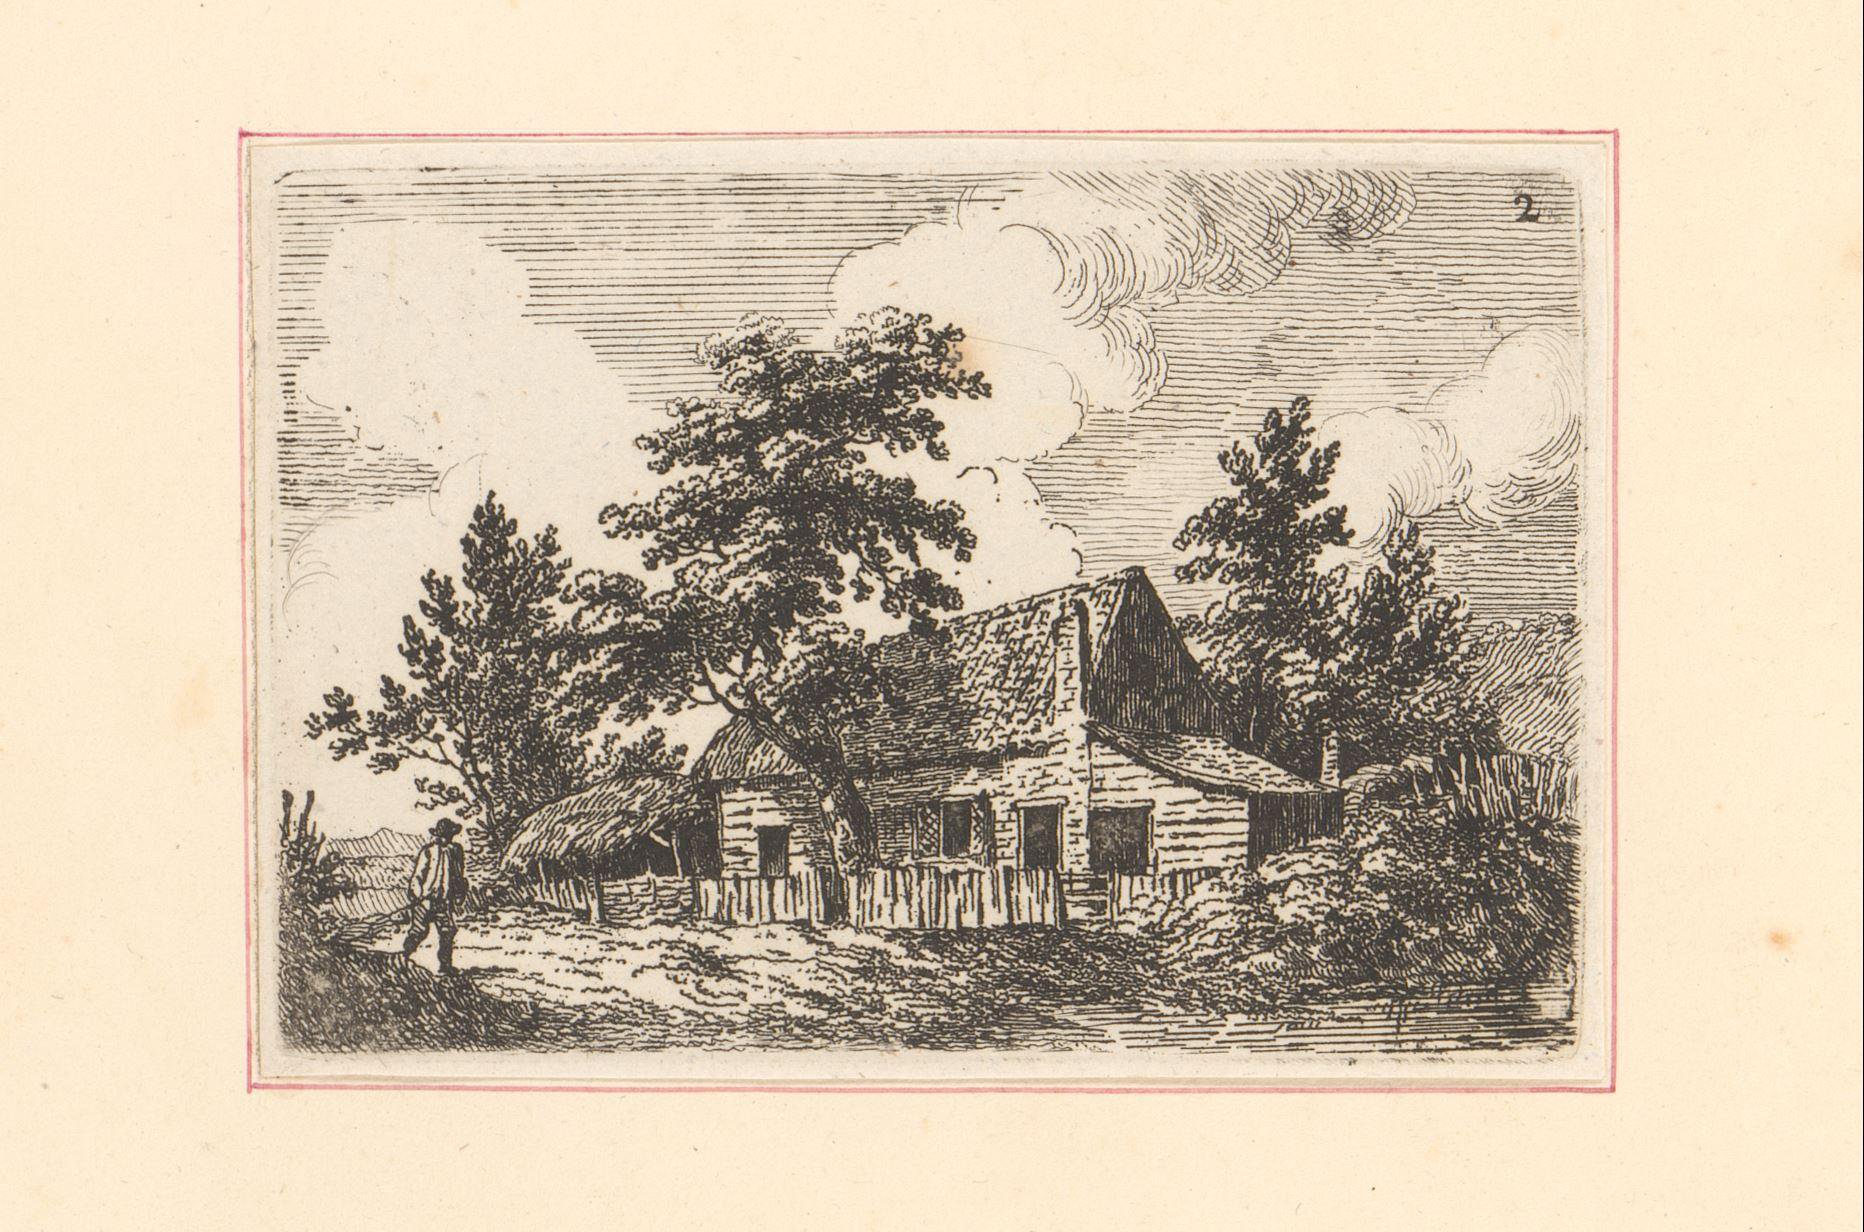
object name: print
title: Etchings by E. Edwards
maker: edward edwards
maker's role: painter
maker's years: 1738-1806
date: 1748-1806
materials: paper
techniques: etching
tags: landscapes (+ landscape with figures, staffage), farm (building)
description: Prent maakt deel uit van een serie van 51 prenten, bestaande uit twee delen met landschappen (36 prenten) en figuren en portretten (15 prenten), voor het eerst uitgegeven in Londen in 1790.